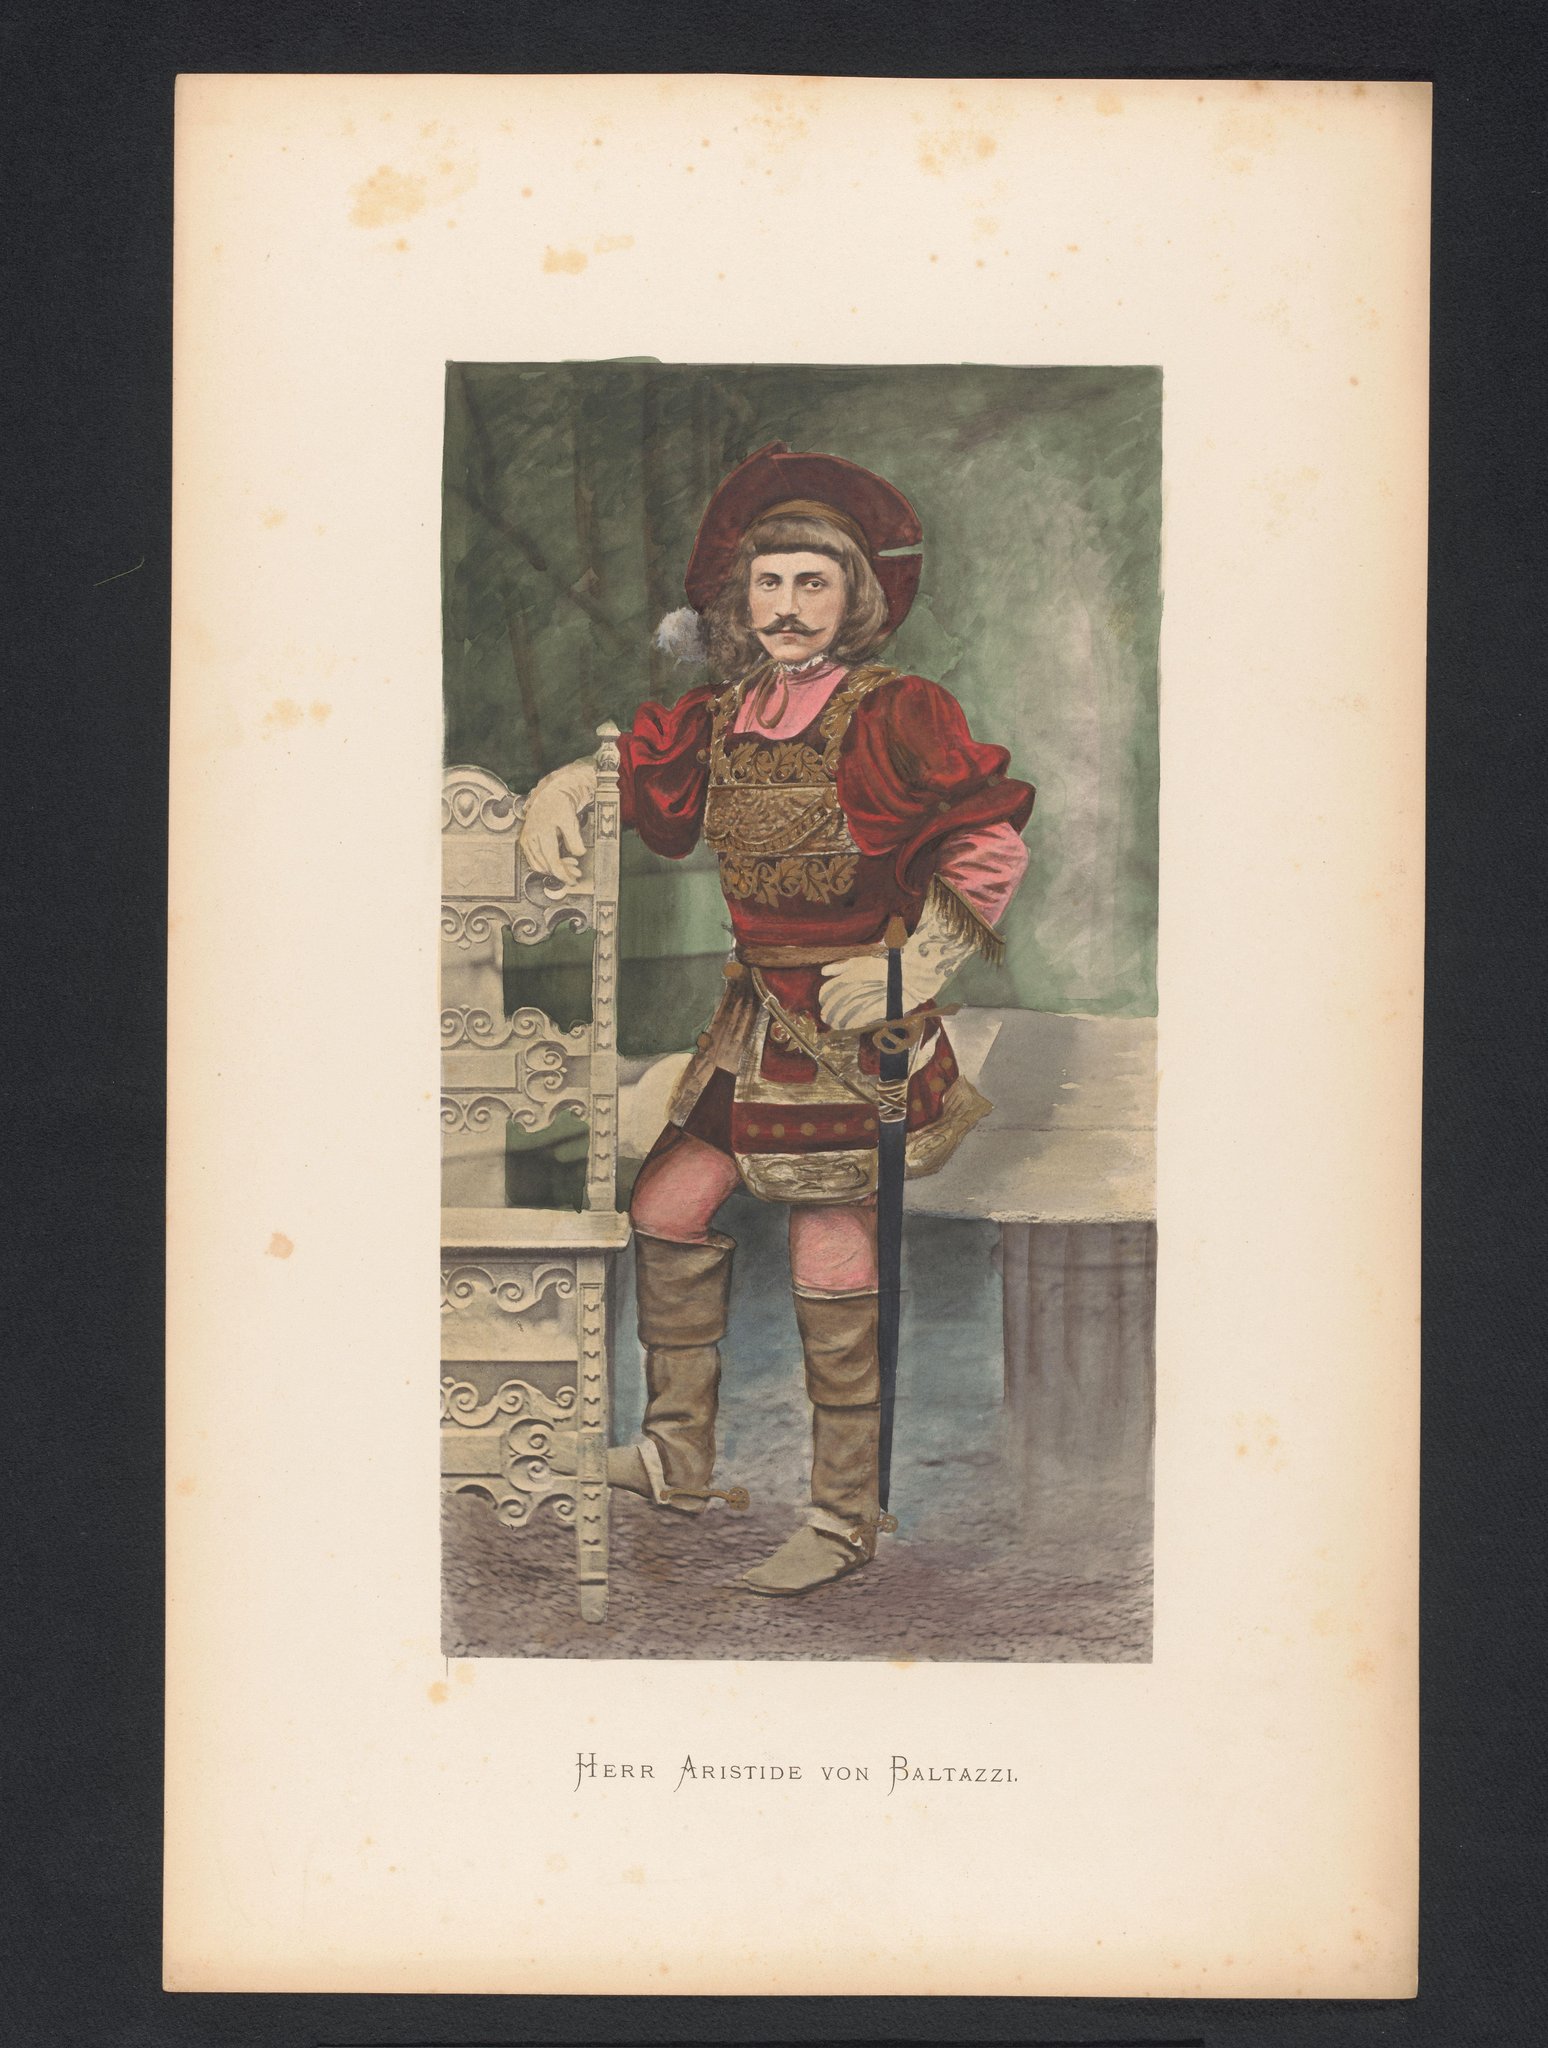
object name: photomechanical print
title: Herr Aristide von Baltazzi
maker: Anonymous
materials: paper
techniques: photograph, hand coloring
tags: vienna, aristocracy; 'aristocratia' (ripa), historical persons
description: Deze prent maakt deel uit van een omslag met 86 prenten op 78 bladen en 11 tekstbladen.